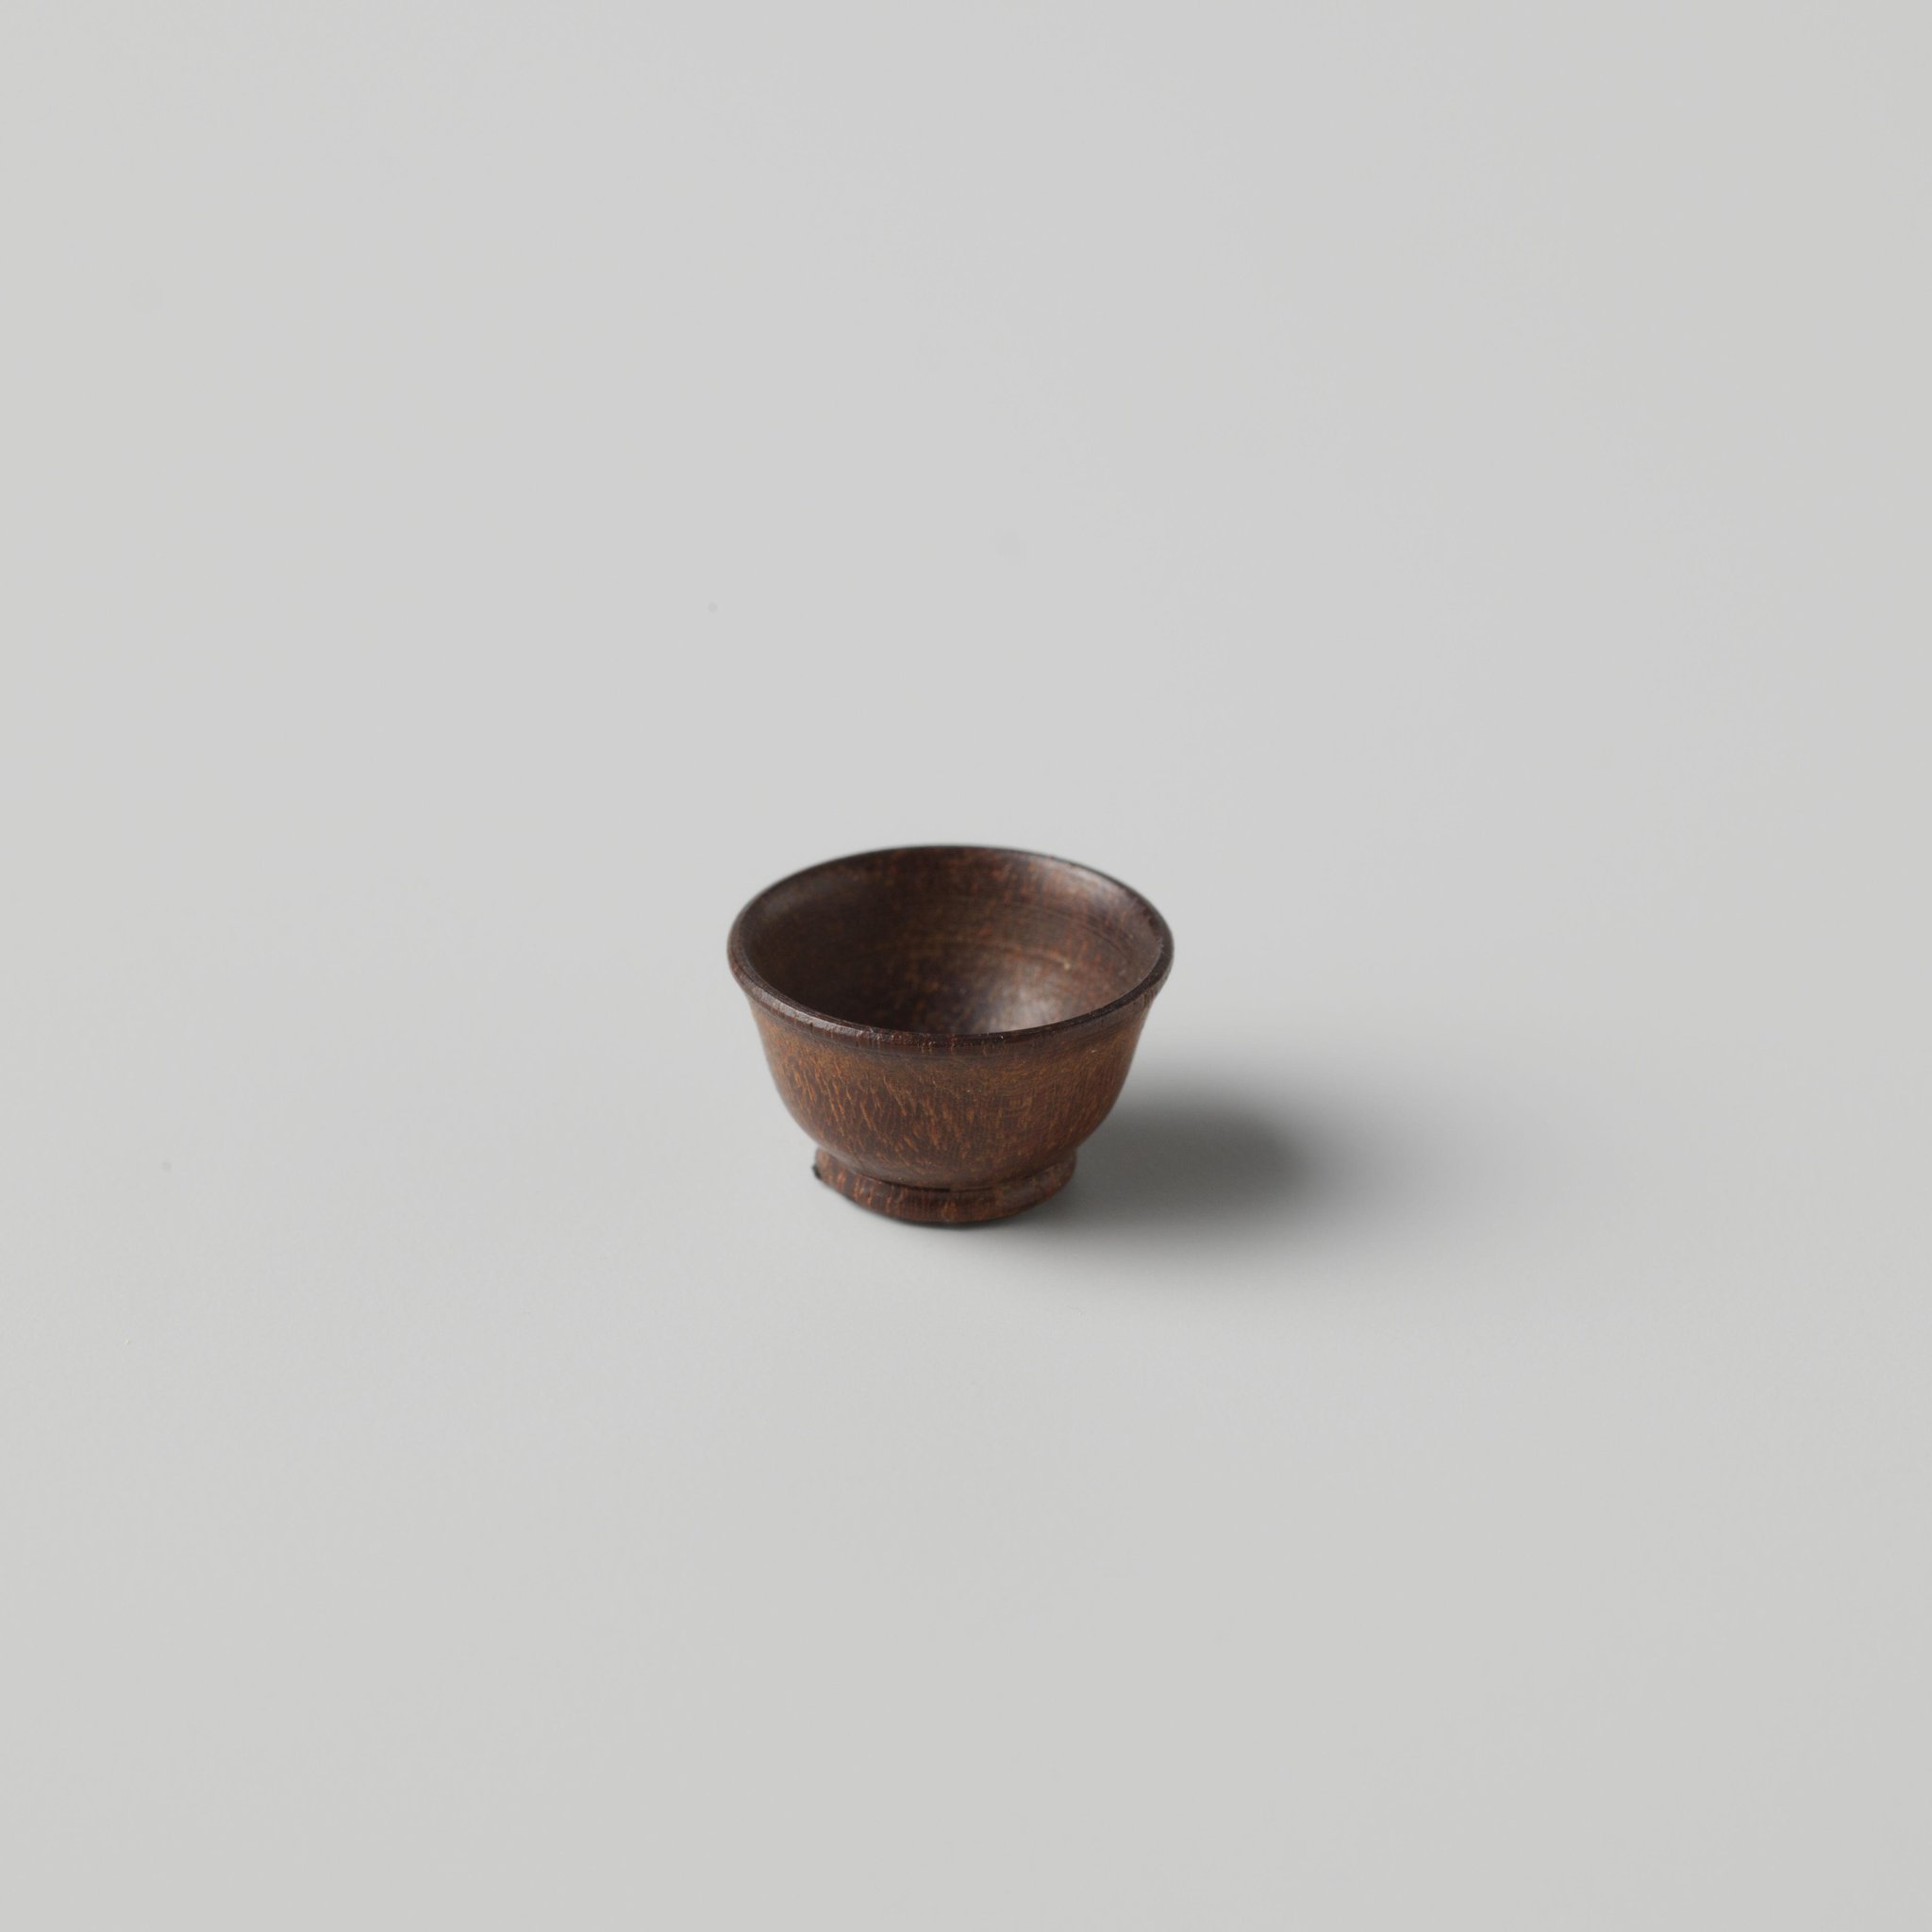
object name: cup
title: Theekop van gedraaid hout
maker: Anonymous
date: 1800-1899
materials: wood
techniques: tropisch hardhout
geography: england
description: Vier koppen gedraaid van een donkere hardhoutsoort.